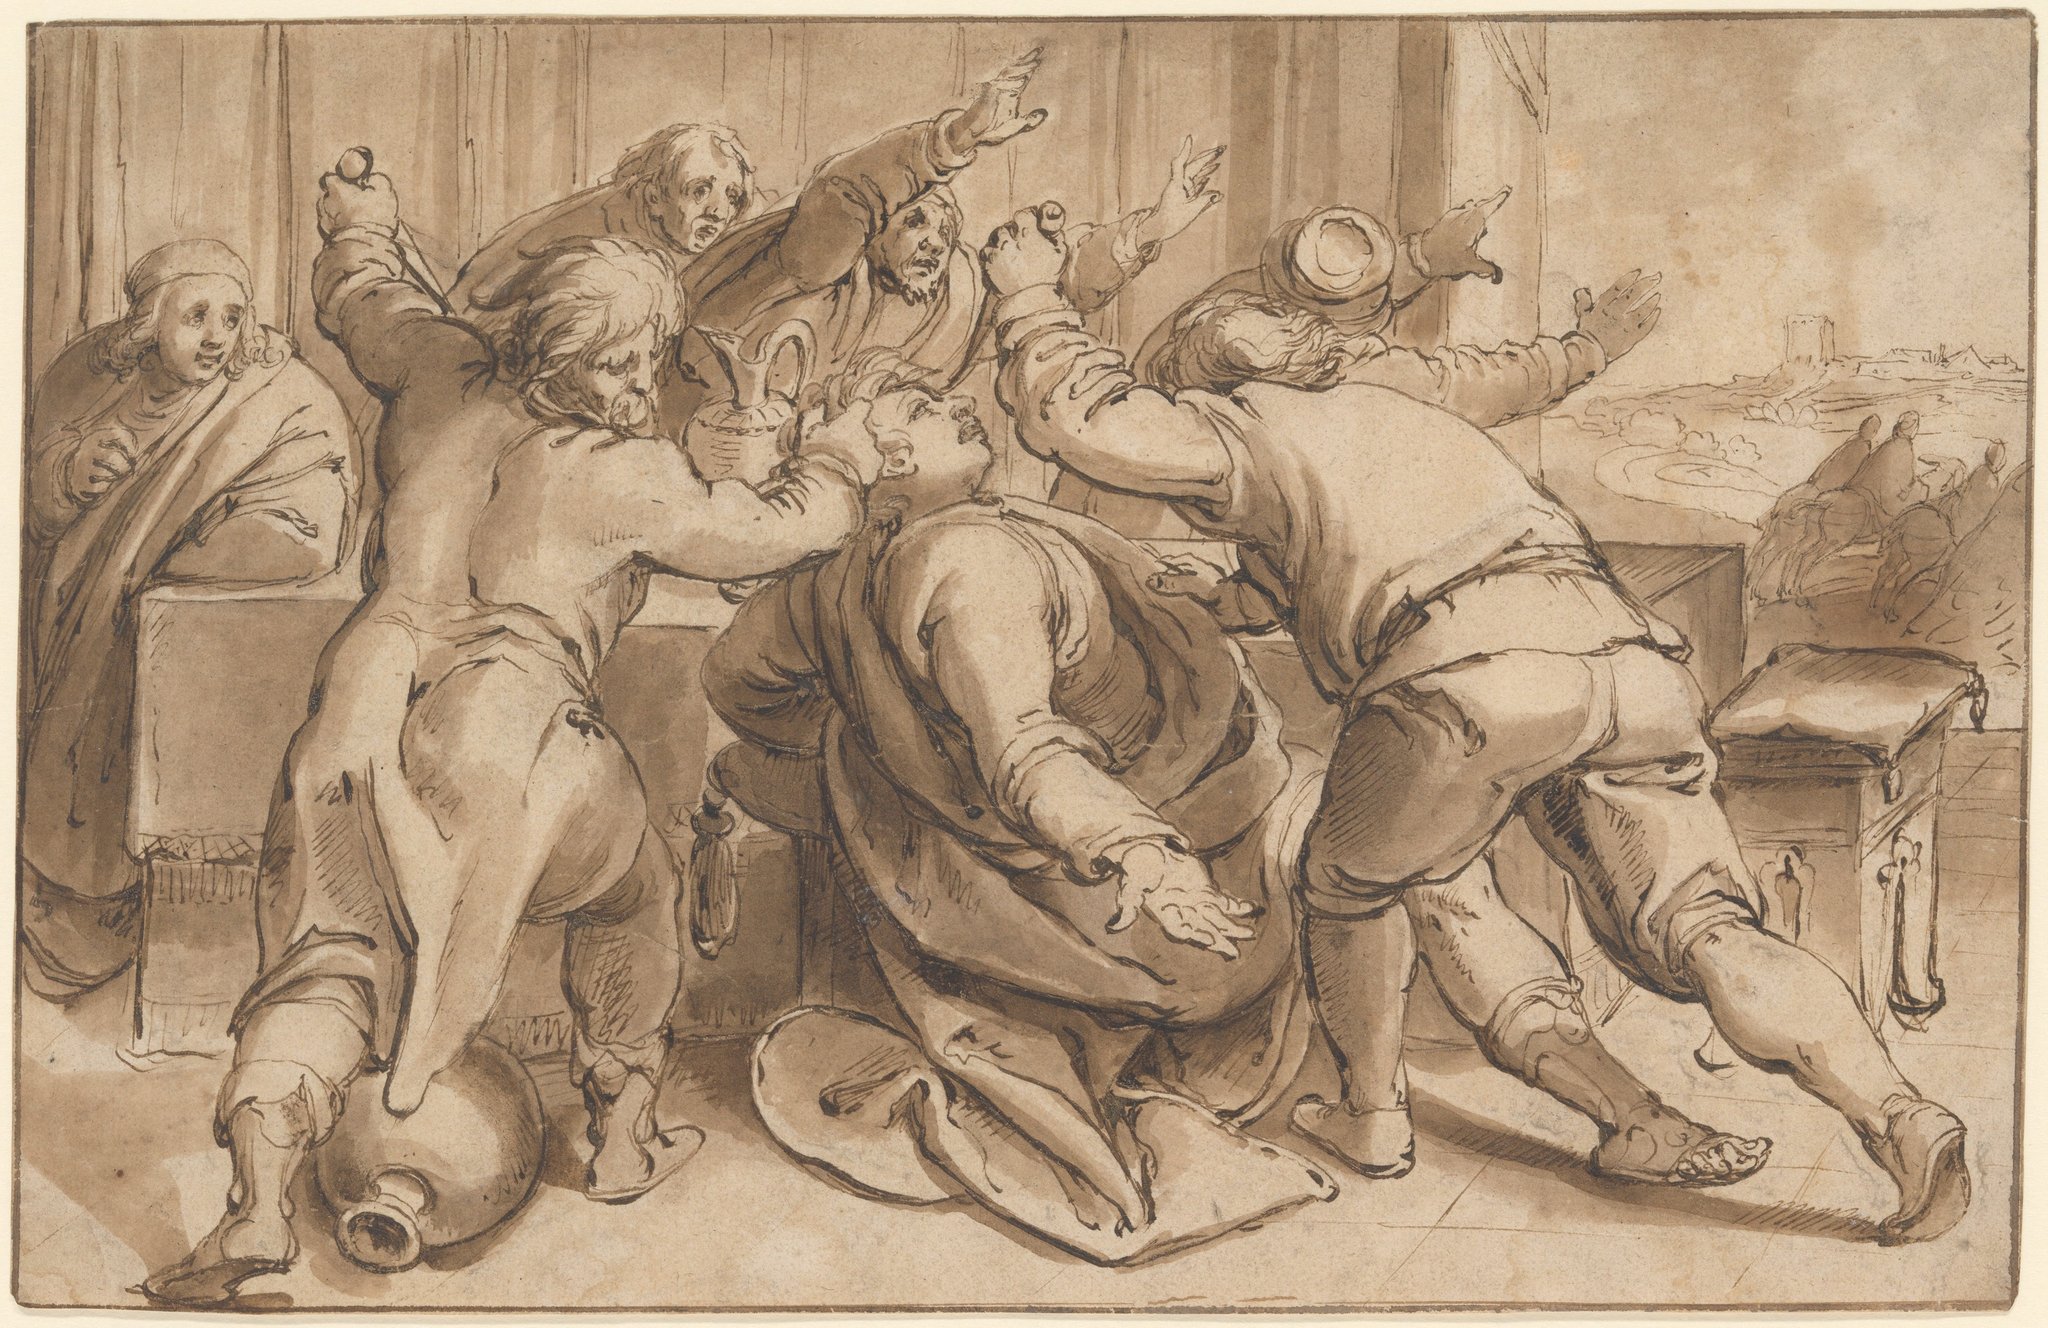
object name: drawing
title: The Servants of Absalom killing Amnon (2 Samuel 13, 28-29); verso: Sketch of a seated woman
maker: karel van mander (i)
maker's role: artist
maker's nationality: netherlandish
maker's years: 1548-1606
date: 1567-1633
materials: chalk, ink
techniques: pen, wash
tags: suffering,men,women,servants